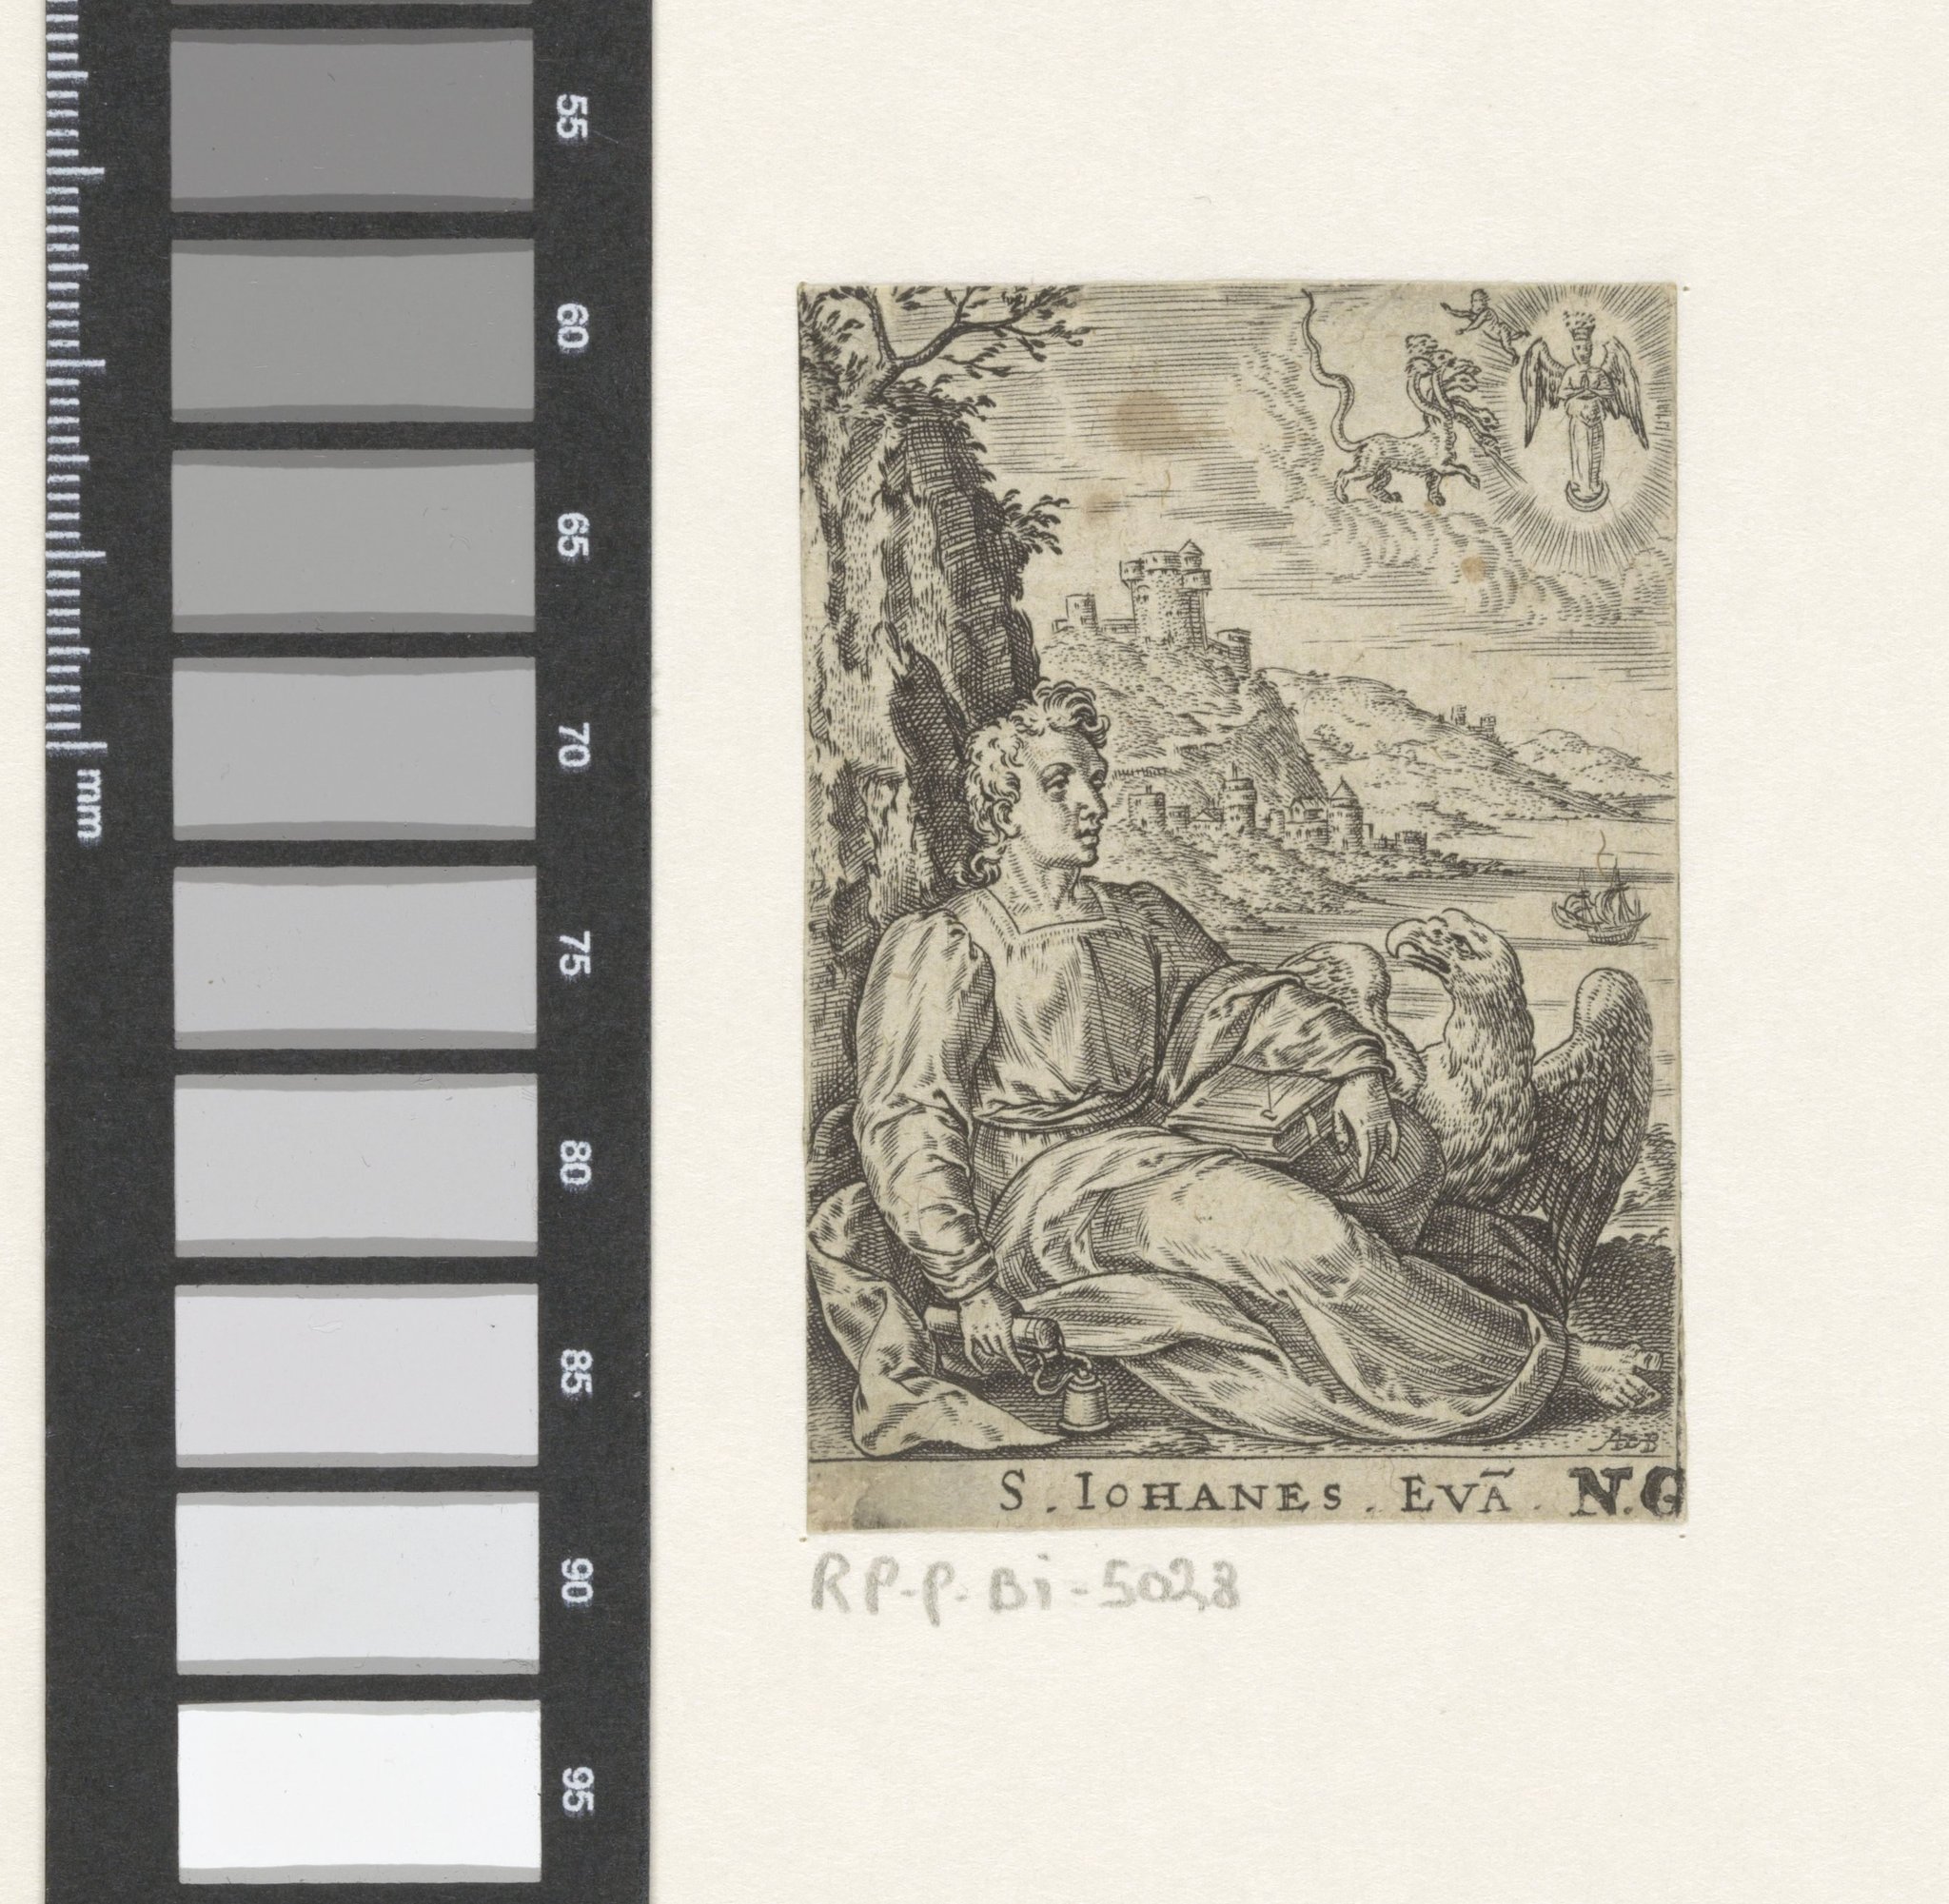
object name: print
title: De vier evangelisten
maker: abraham de bruyn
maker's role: print maker, publisher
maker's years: 1540-1587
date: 1578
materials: paper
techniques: engraving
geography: antwerp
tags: the apostle john the evangelist; possible attributes: book, cauldron, chalice with snake, eagle, palm, scroll, john (writing) on the island of patmos, possibly the eagle beside him, the revelation of john, the apocalypse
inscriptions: collector's mark: Lugt 1967 of 1968, collector's mark: Lugt 2227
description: De evangelist Johannes. Hij ligt tegen een rots op het eiland Padmos. Achter hem een landschap. In zijn linkerhand houdt hij zijn evangelie. Naast hem staat de adelaar, het symbolisch dier van zijn evangelie. In de lucht ziet hij visioenen van de Apocalyps.